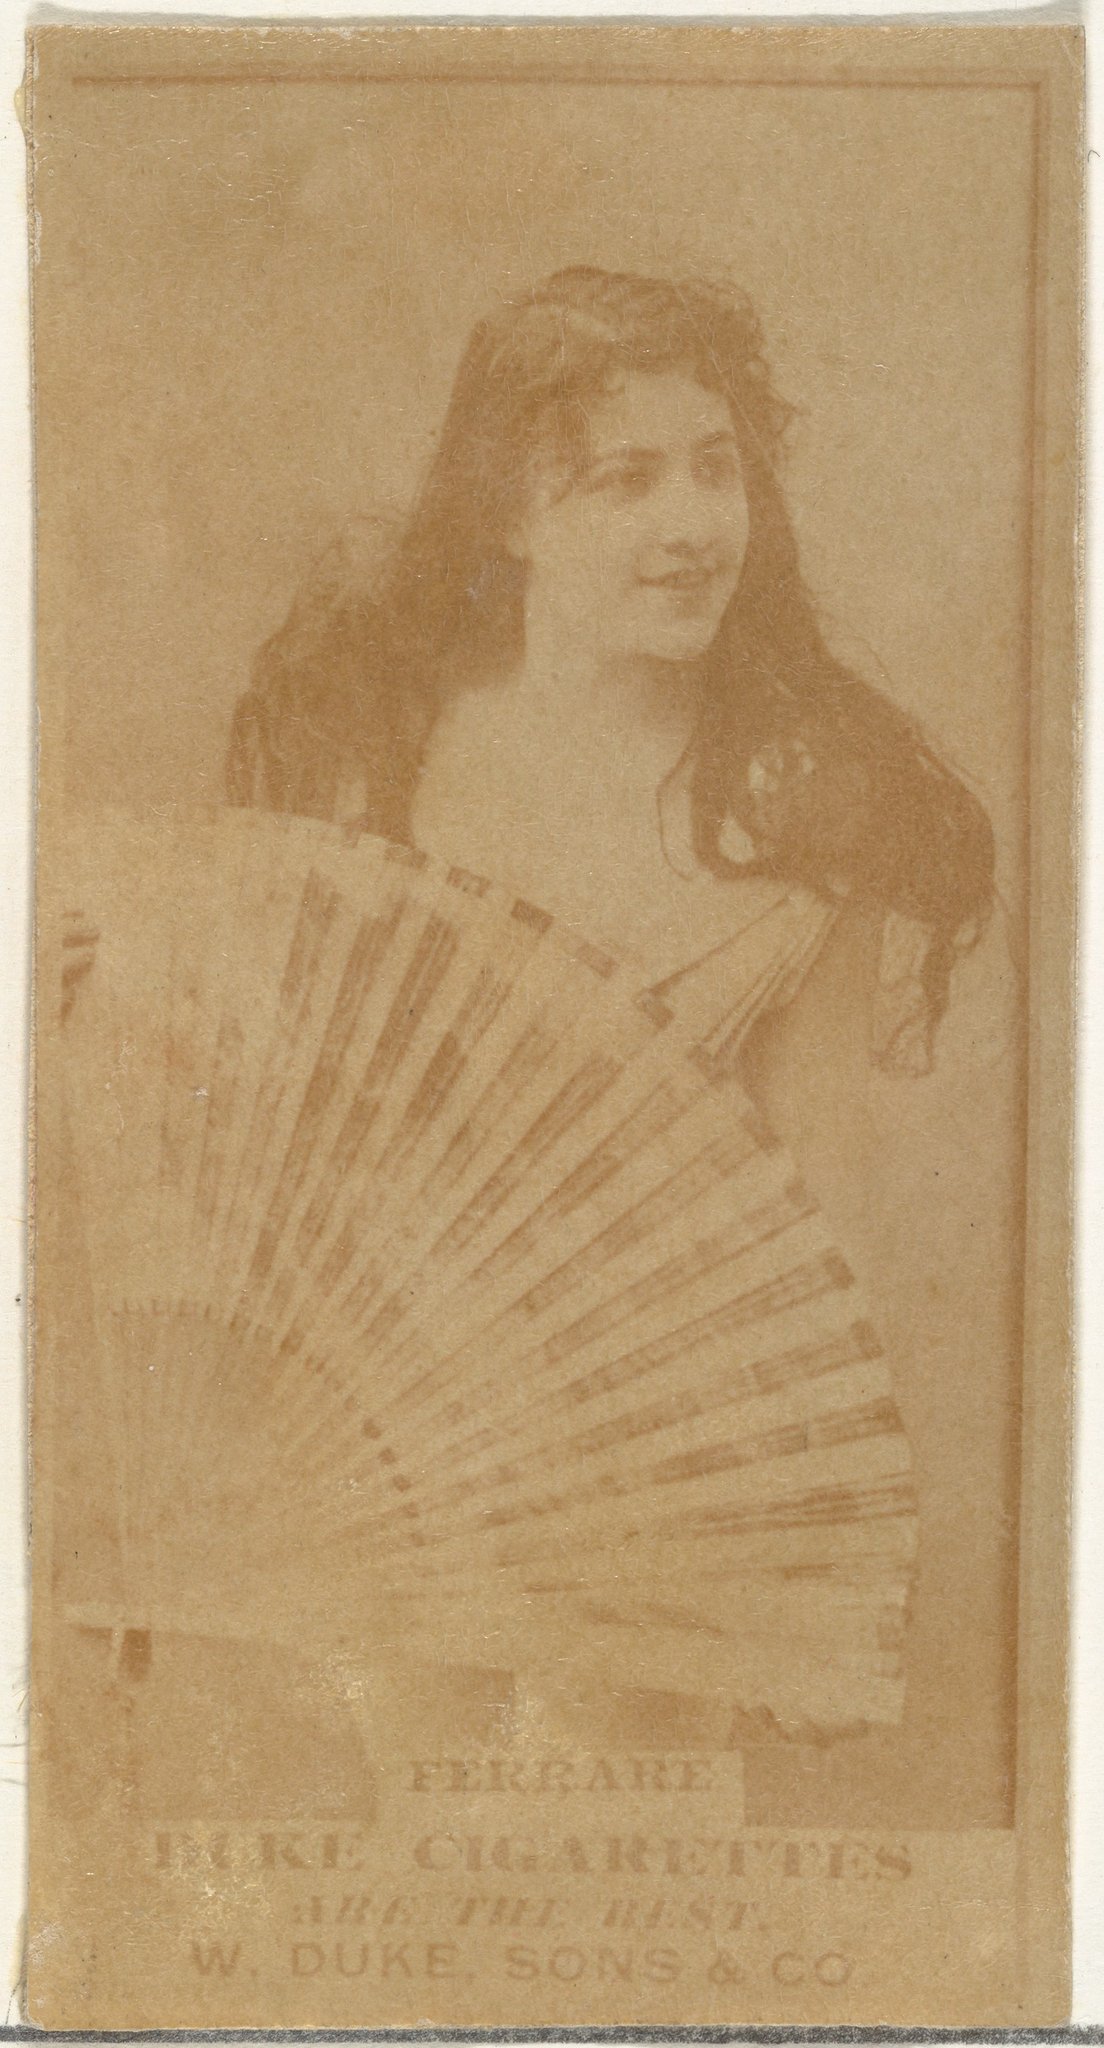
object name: photograph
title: Miss Ferrare, from the Actors and Actresses series (N145-7) issued by Duke Sons & Co. to promote Duke Cigarettes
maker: w. duke, sons & co.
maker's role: publisher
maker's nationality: american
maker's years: 1870-1920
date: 1880-1889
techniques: albumen silver print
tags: fans,portraits,women,actresses